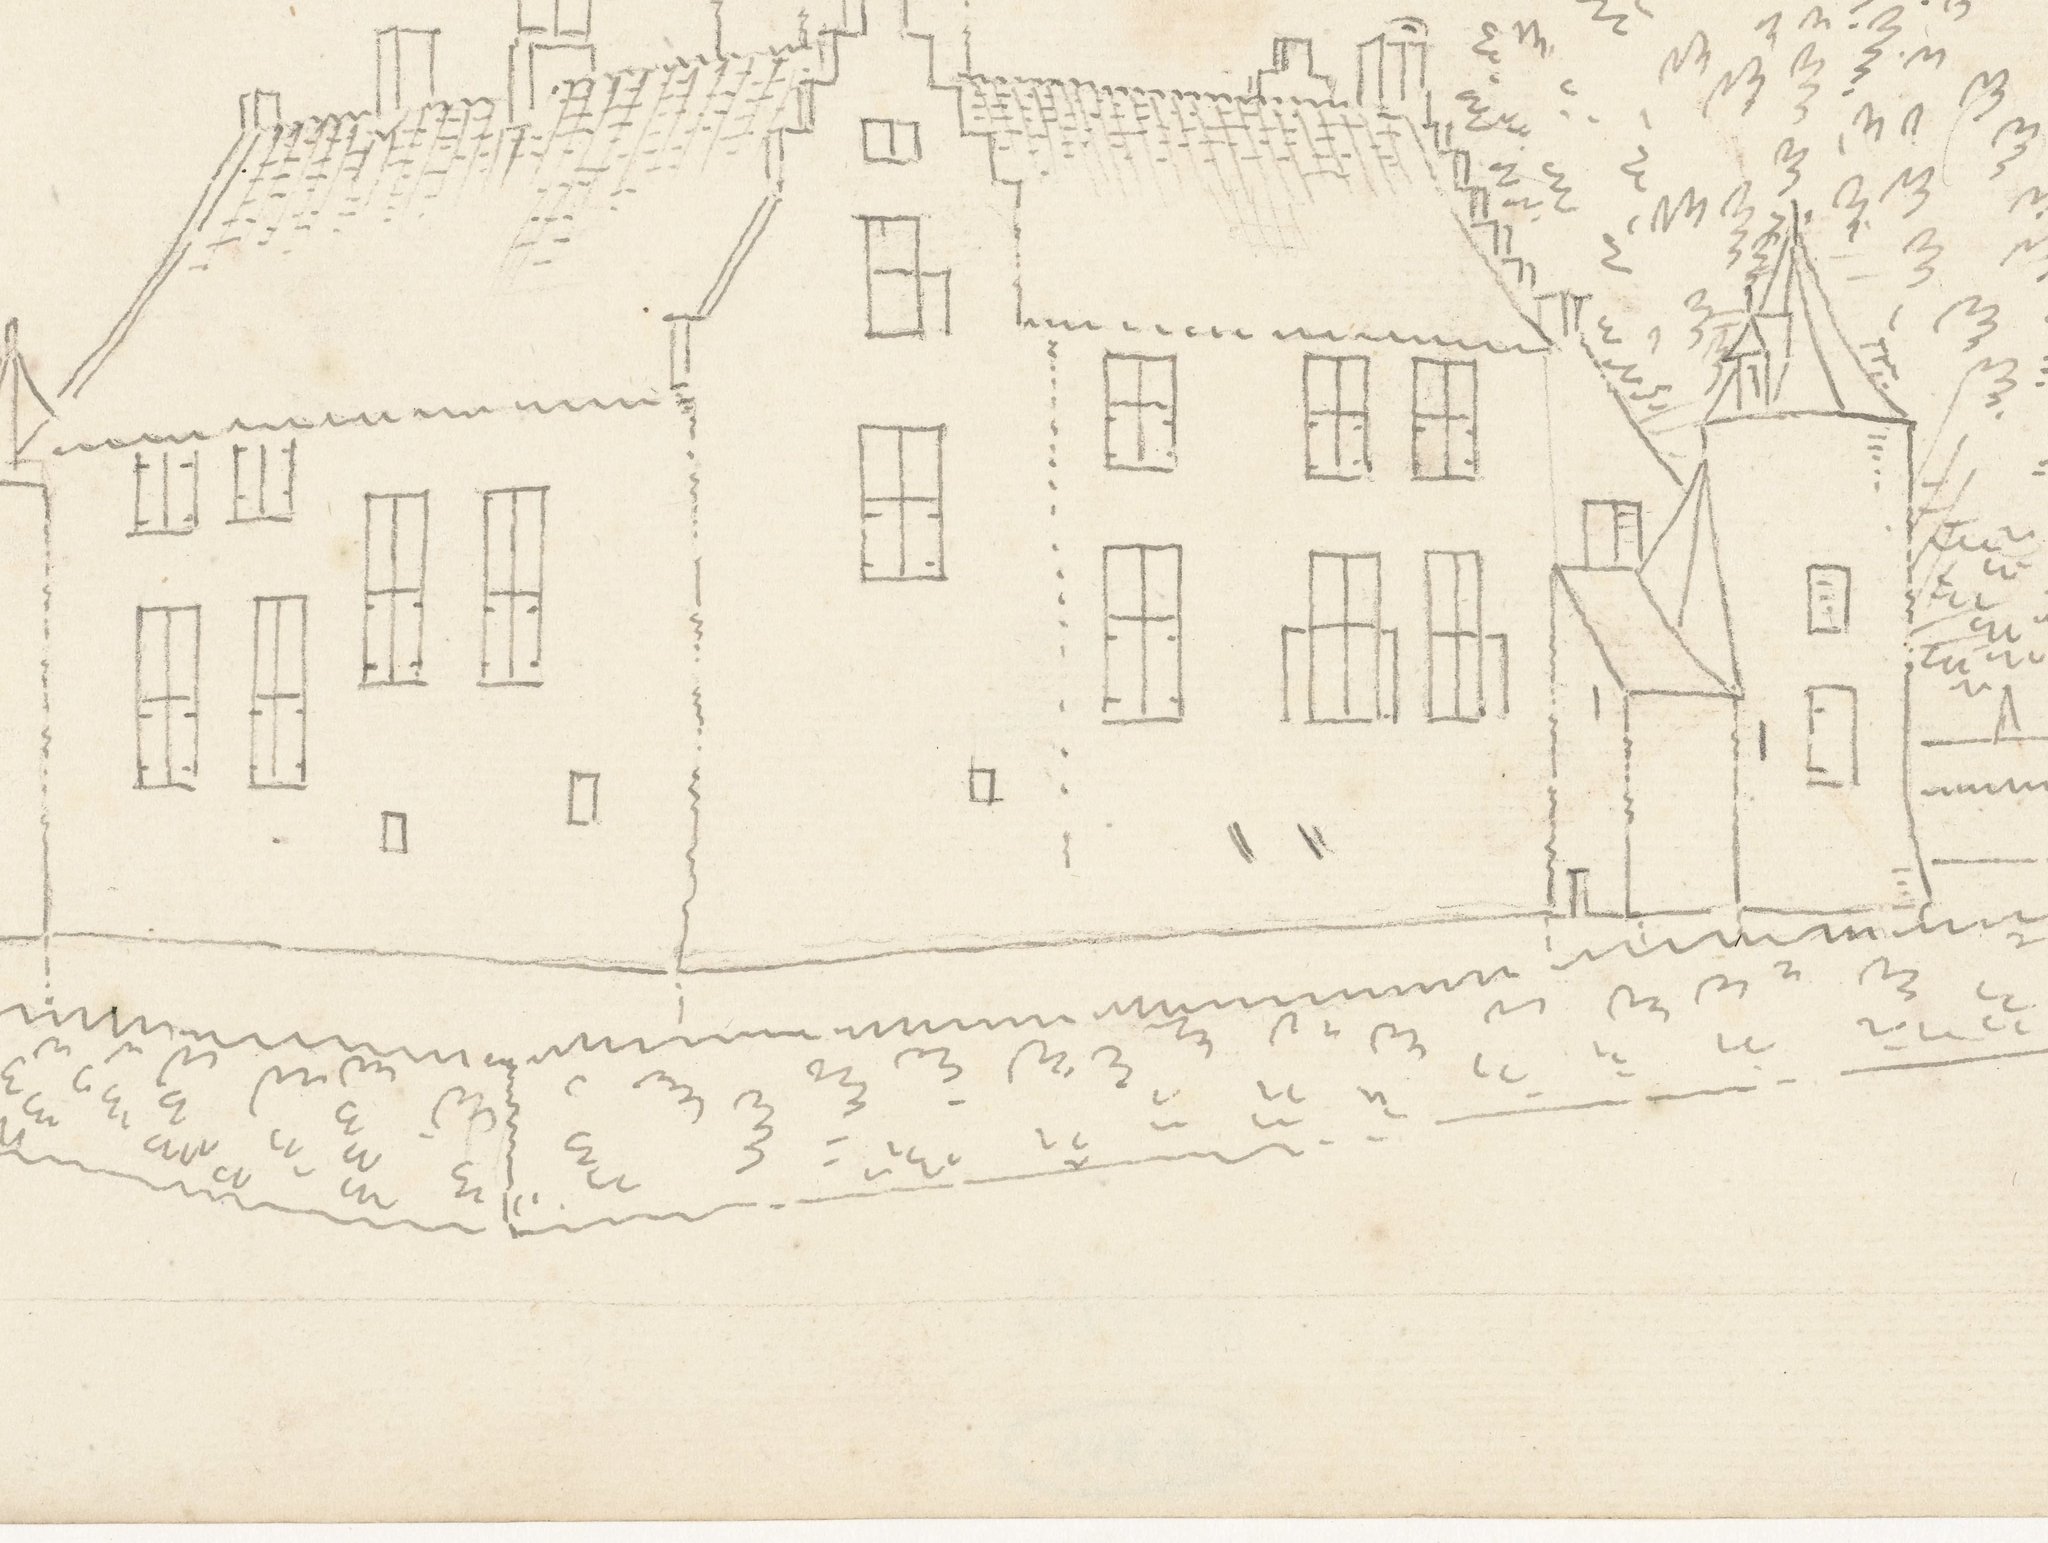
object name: drawing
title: Het kasteel Limburg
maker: cornelis pronk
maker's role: draughtsman, painter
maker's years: 1691-1759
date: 1729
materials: ink, paper, pencil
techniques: pen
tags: castle